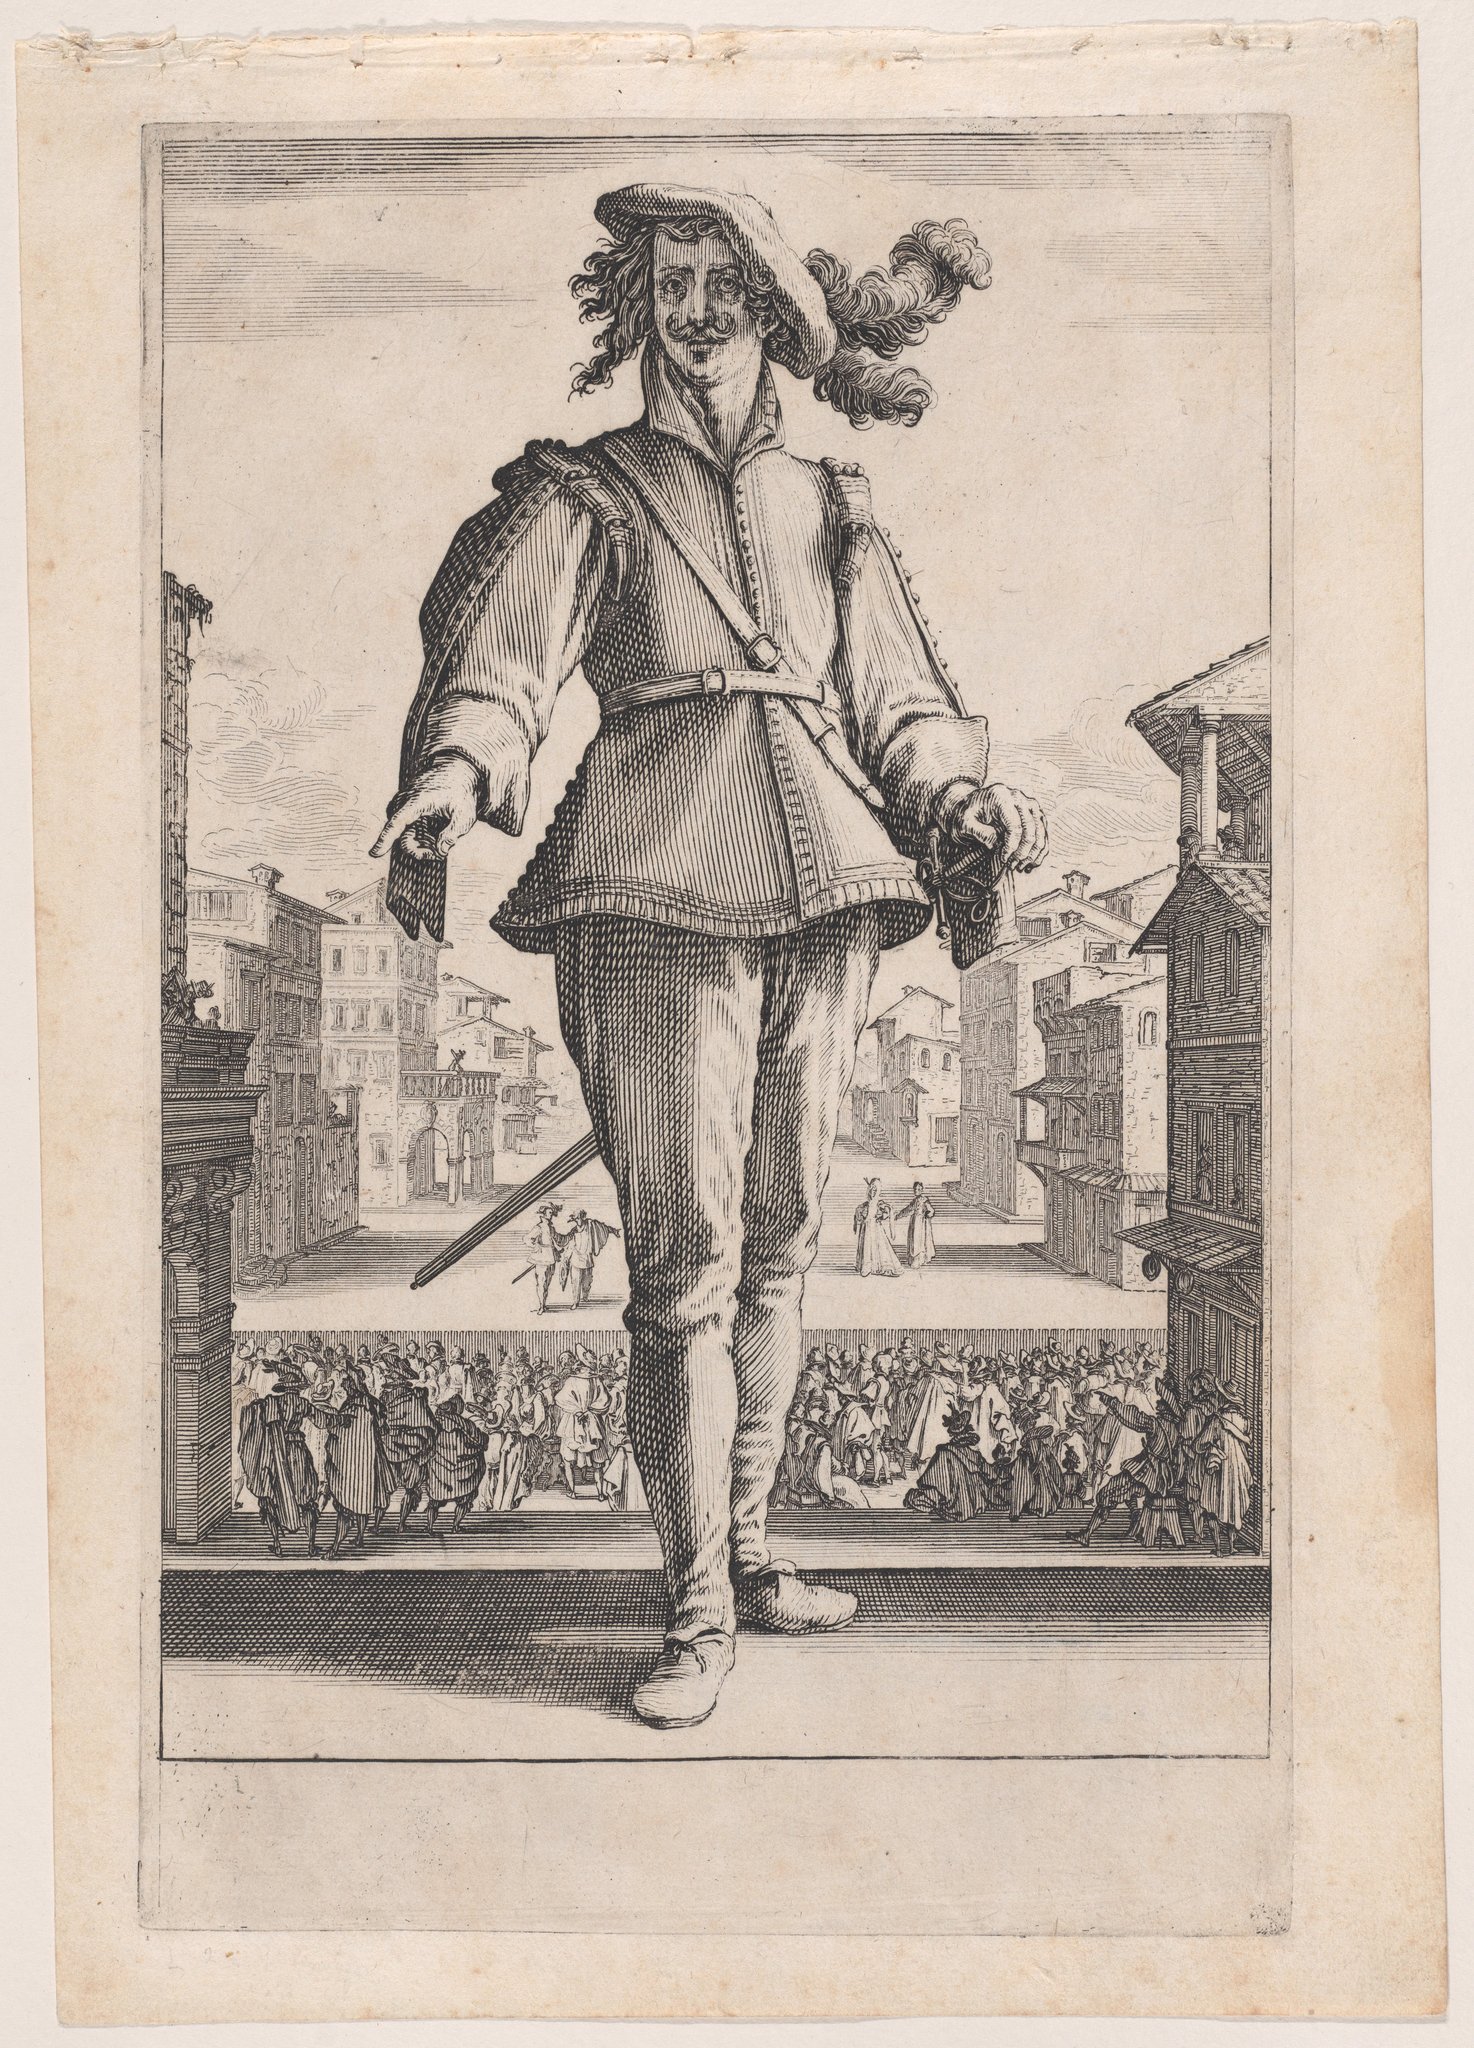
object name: print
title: Le Captain ou L'Amoureux, from "Les Trois Pantalons pièces appélees Les Trois Acteurs" (The Three Pants also called the Three Actors)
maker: jacques callot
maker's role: artist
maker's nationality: french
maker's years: 1592-1635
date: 1618-1620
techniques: engraving, etching